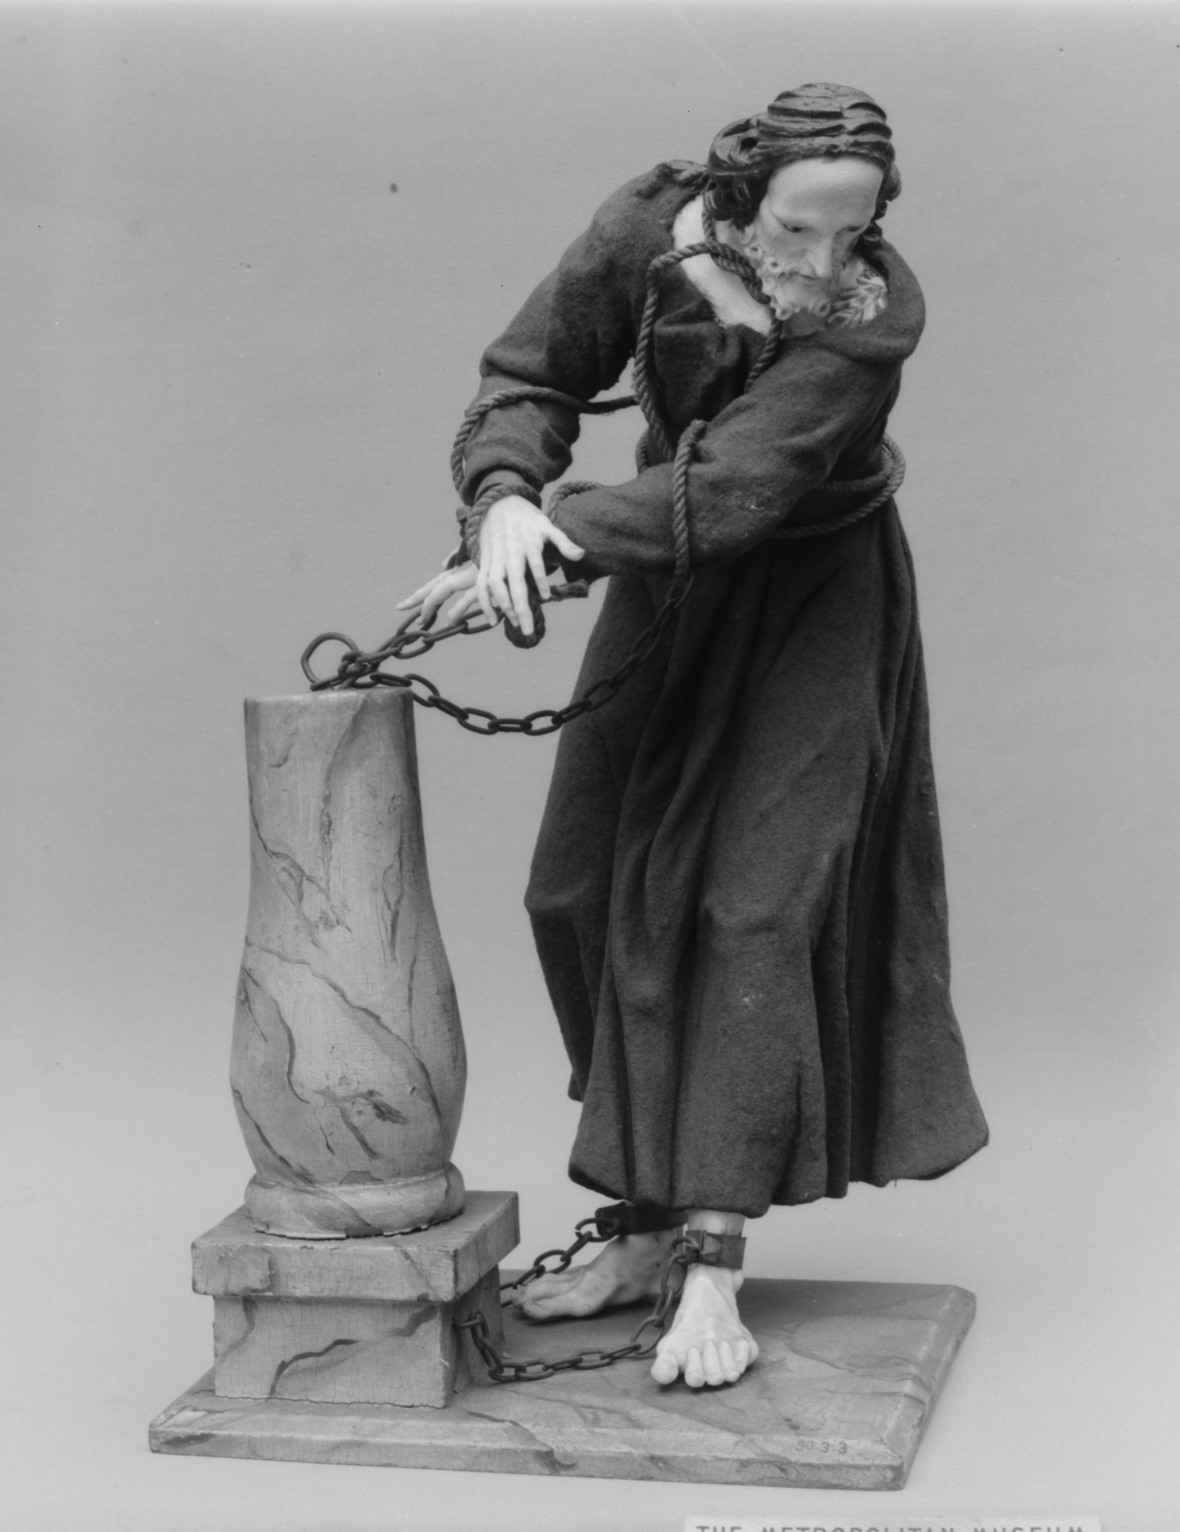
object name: statuette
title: Christ Bound to the Column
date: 1601-1633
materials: ivory, wood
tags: columns,christ